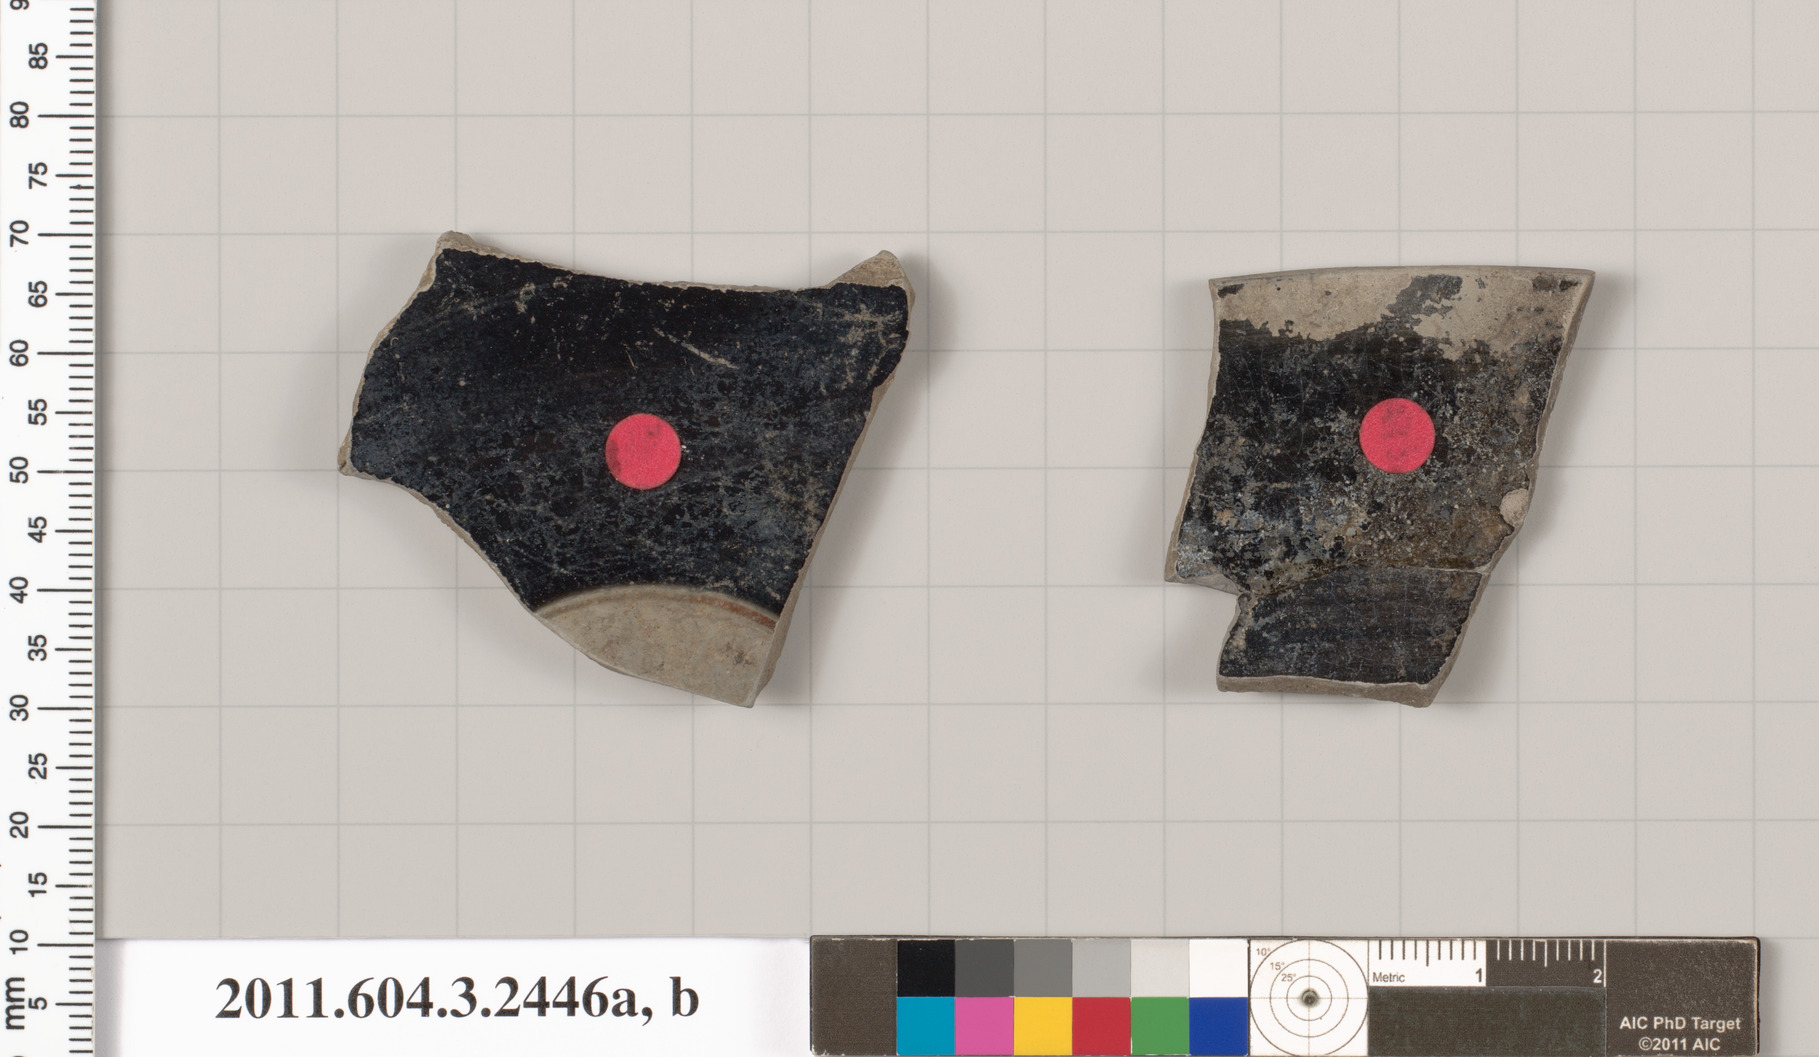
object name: kylix fragment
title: Terracotta fragments of a kylix (drinking cup)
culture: greek, attic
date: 530-510 BCE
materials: terracotta